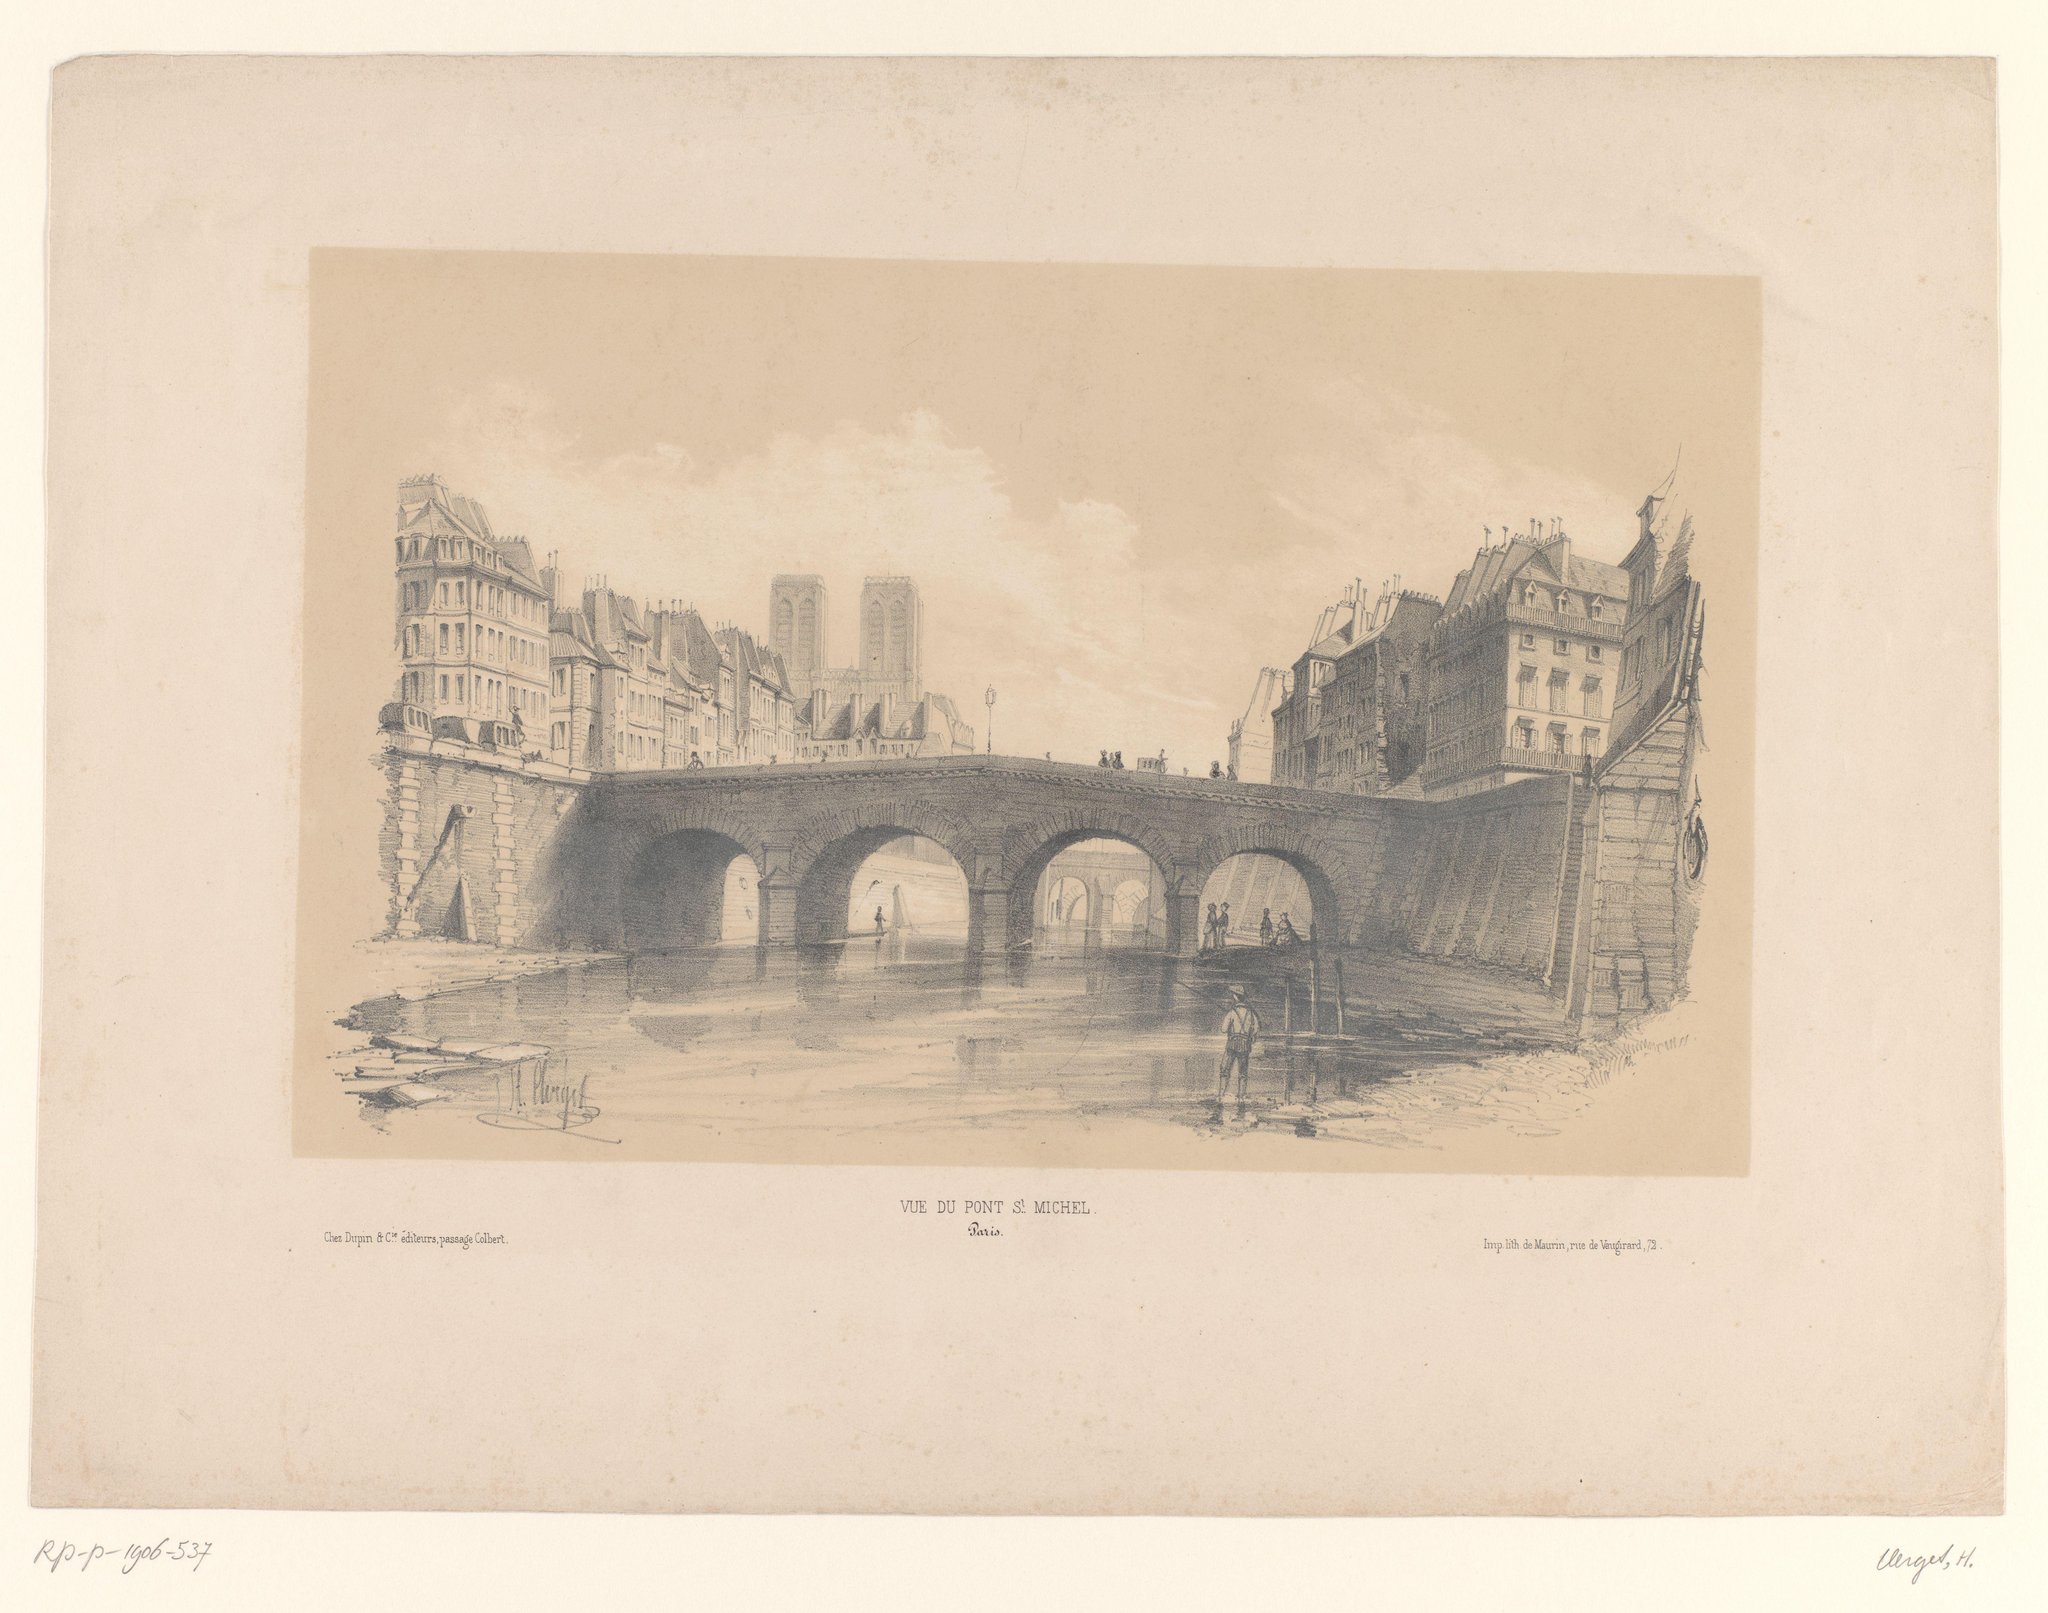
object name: print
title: Fragmenten van landschappen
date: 1840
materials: paper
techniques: tone lithography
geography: paris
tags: bridge in city across river, canal, etc. (+ city(-scape) with figures, staffage)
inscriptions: collector's mark: Lugt 2228a